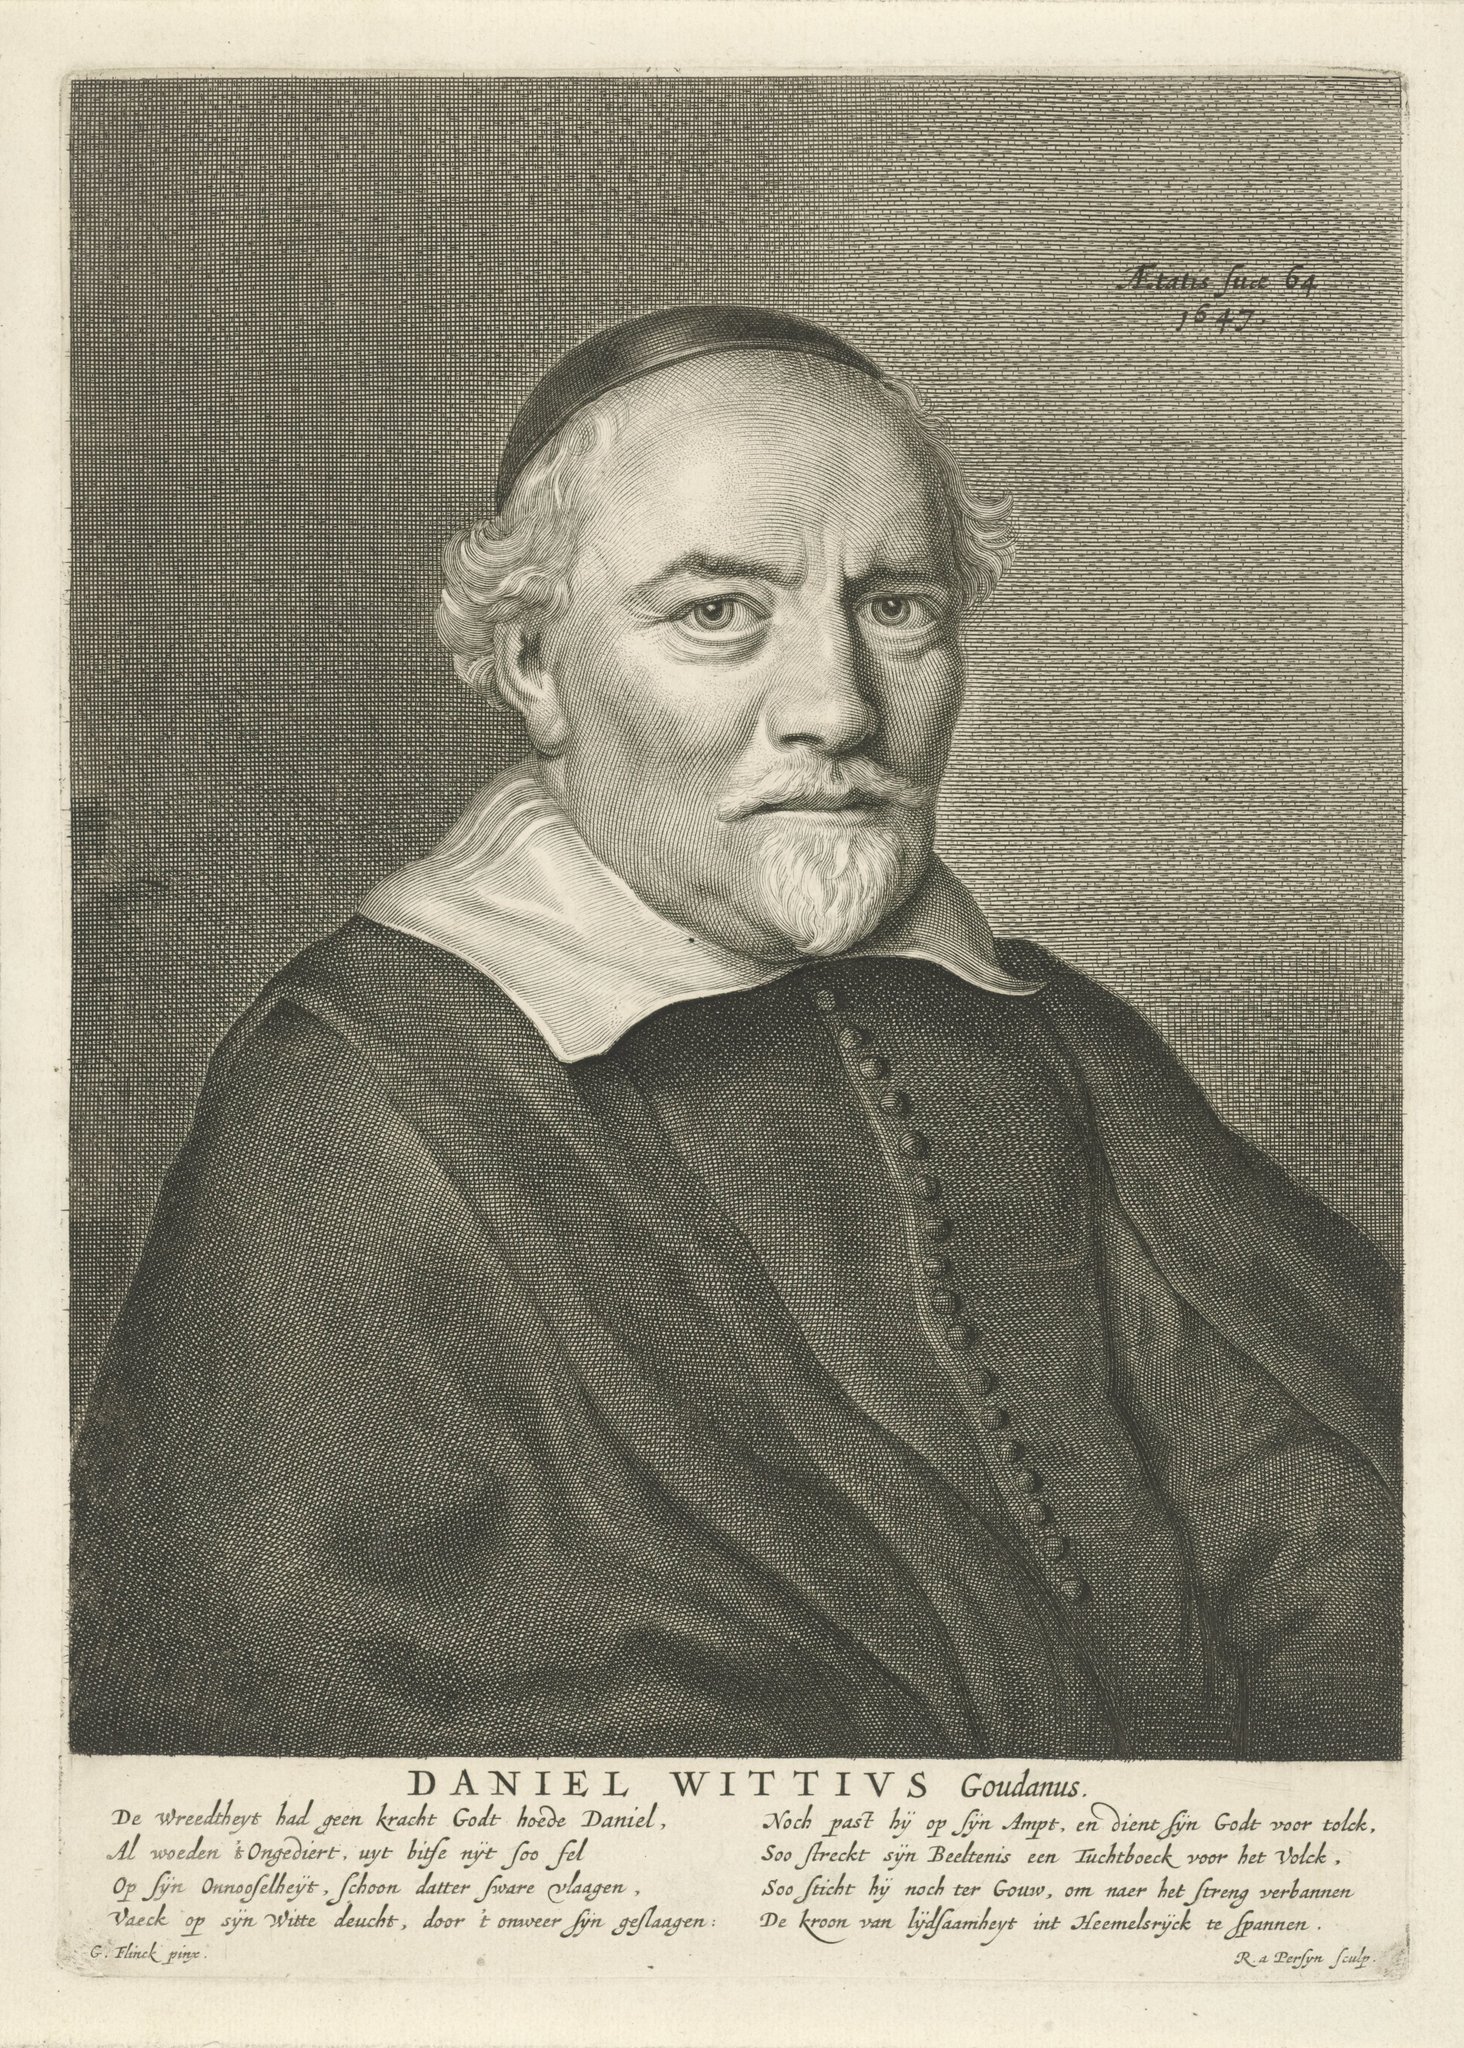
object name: print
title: Portret van Daniël Wittius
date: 1647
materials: paper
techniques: engraving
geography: gouda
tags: predikant, daniël wittius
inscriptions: collector's mark: Lugt 2228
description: Portret van Daniël Wittius, predikant te Schoonhoven en Gouda, op 64-jarige leeftijd. In de marge een achtregelig lofdicht, in twee kolommen, in het Nederlands.